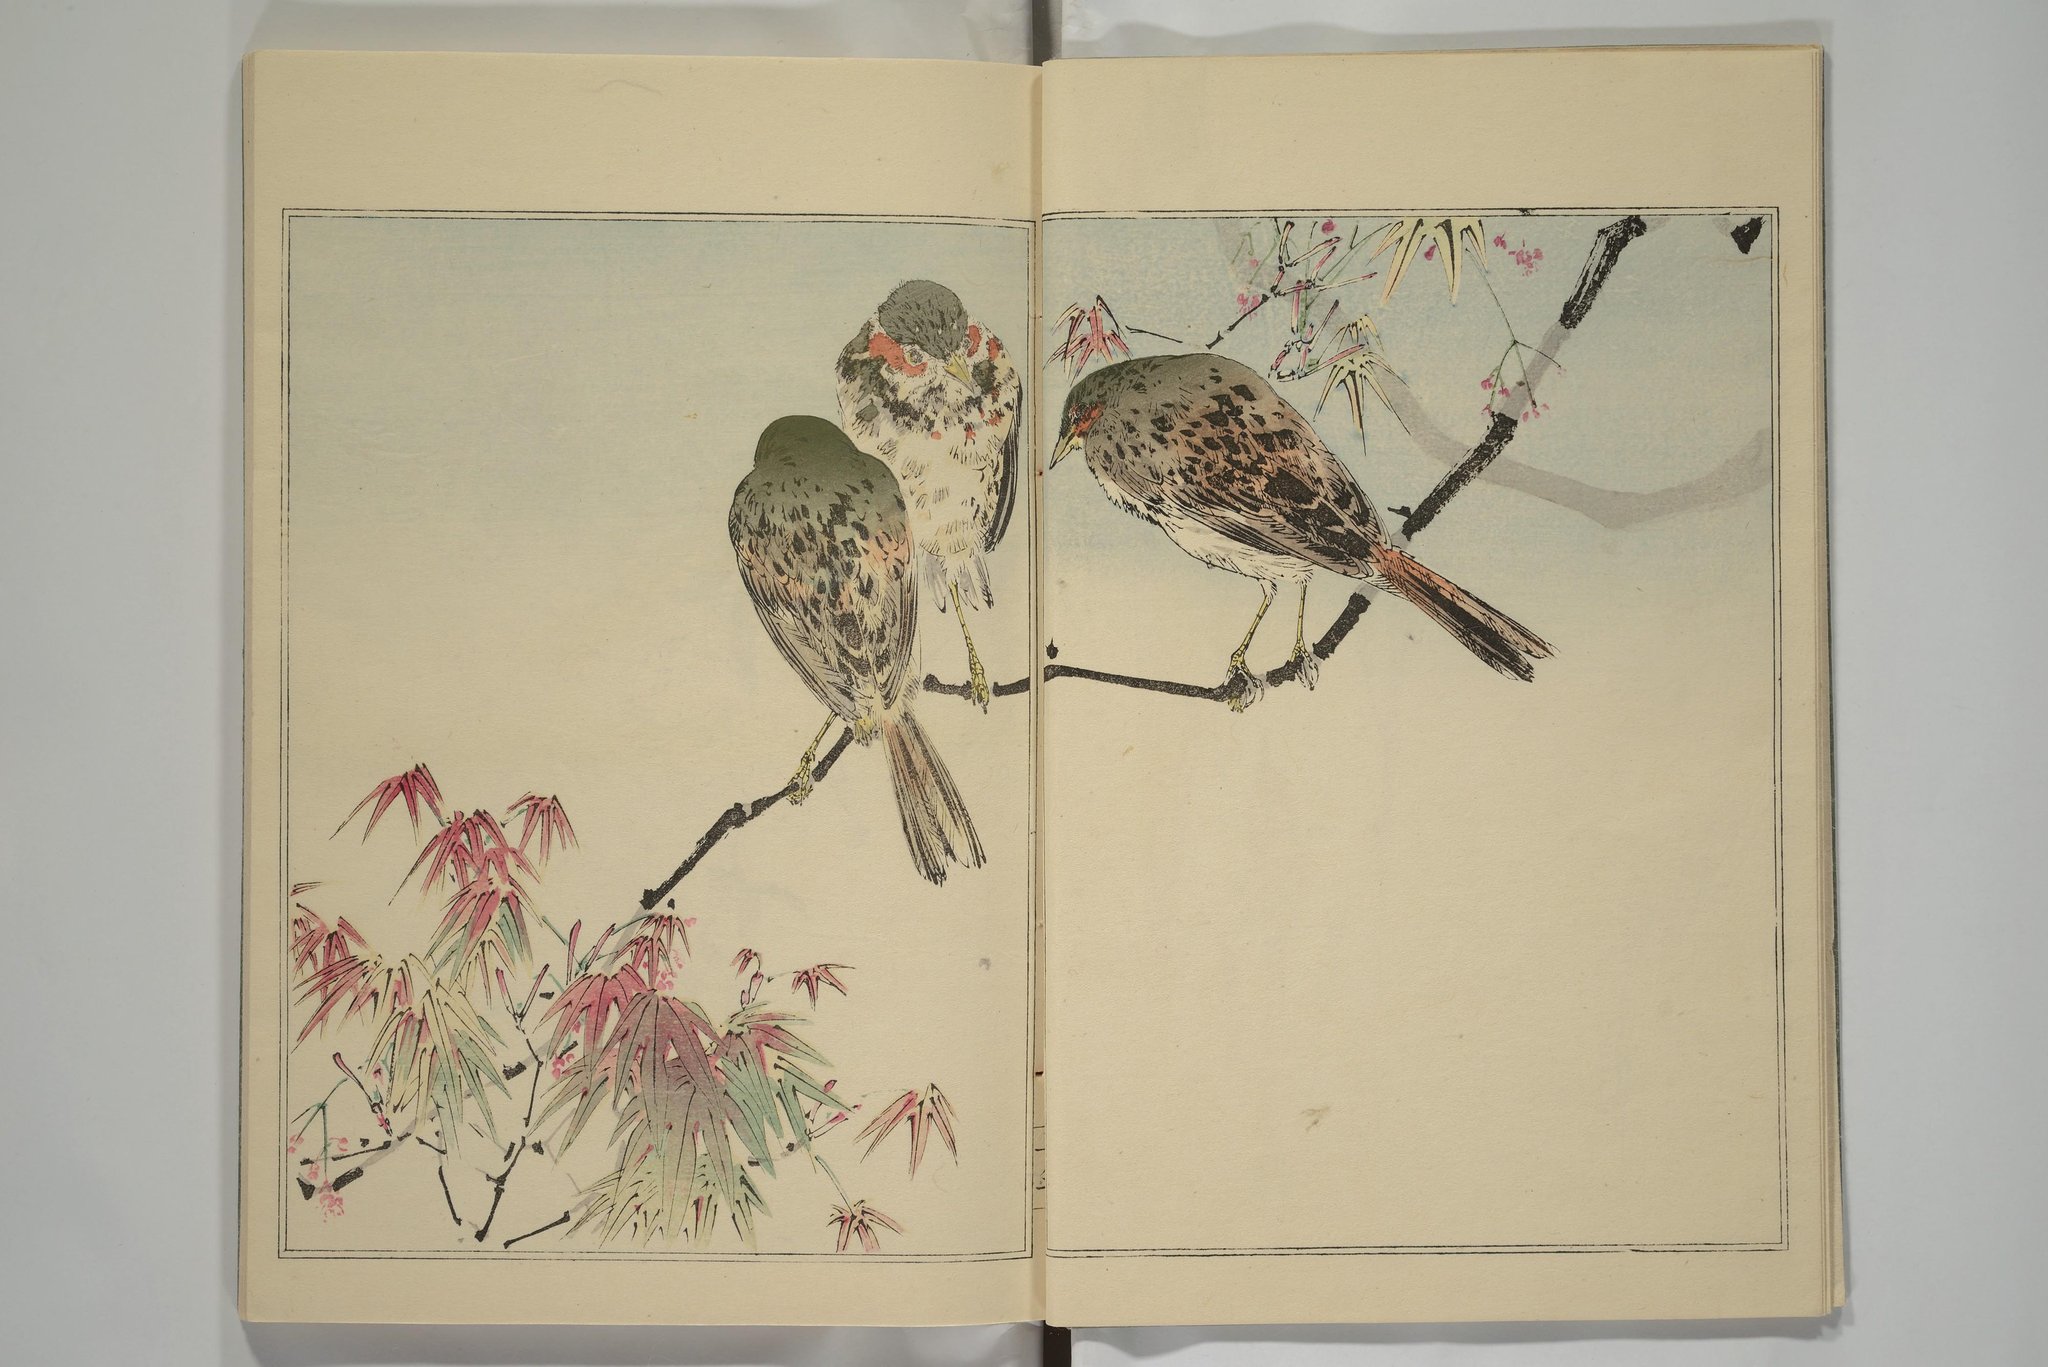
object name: illustrated book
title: Picture Album of Birds and Flowers (Kachō gafu) 華鳥画譜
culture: japanese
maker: watanabe seitei 渡辺省亭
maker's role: artist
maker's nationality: japanese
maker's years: 1851-1918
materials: ink, paper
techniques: woodblock print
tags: birds,flowers